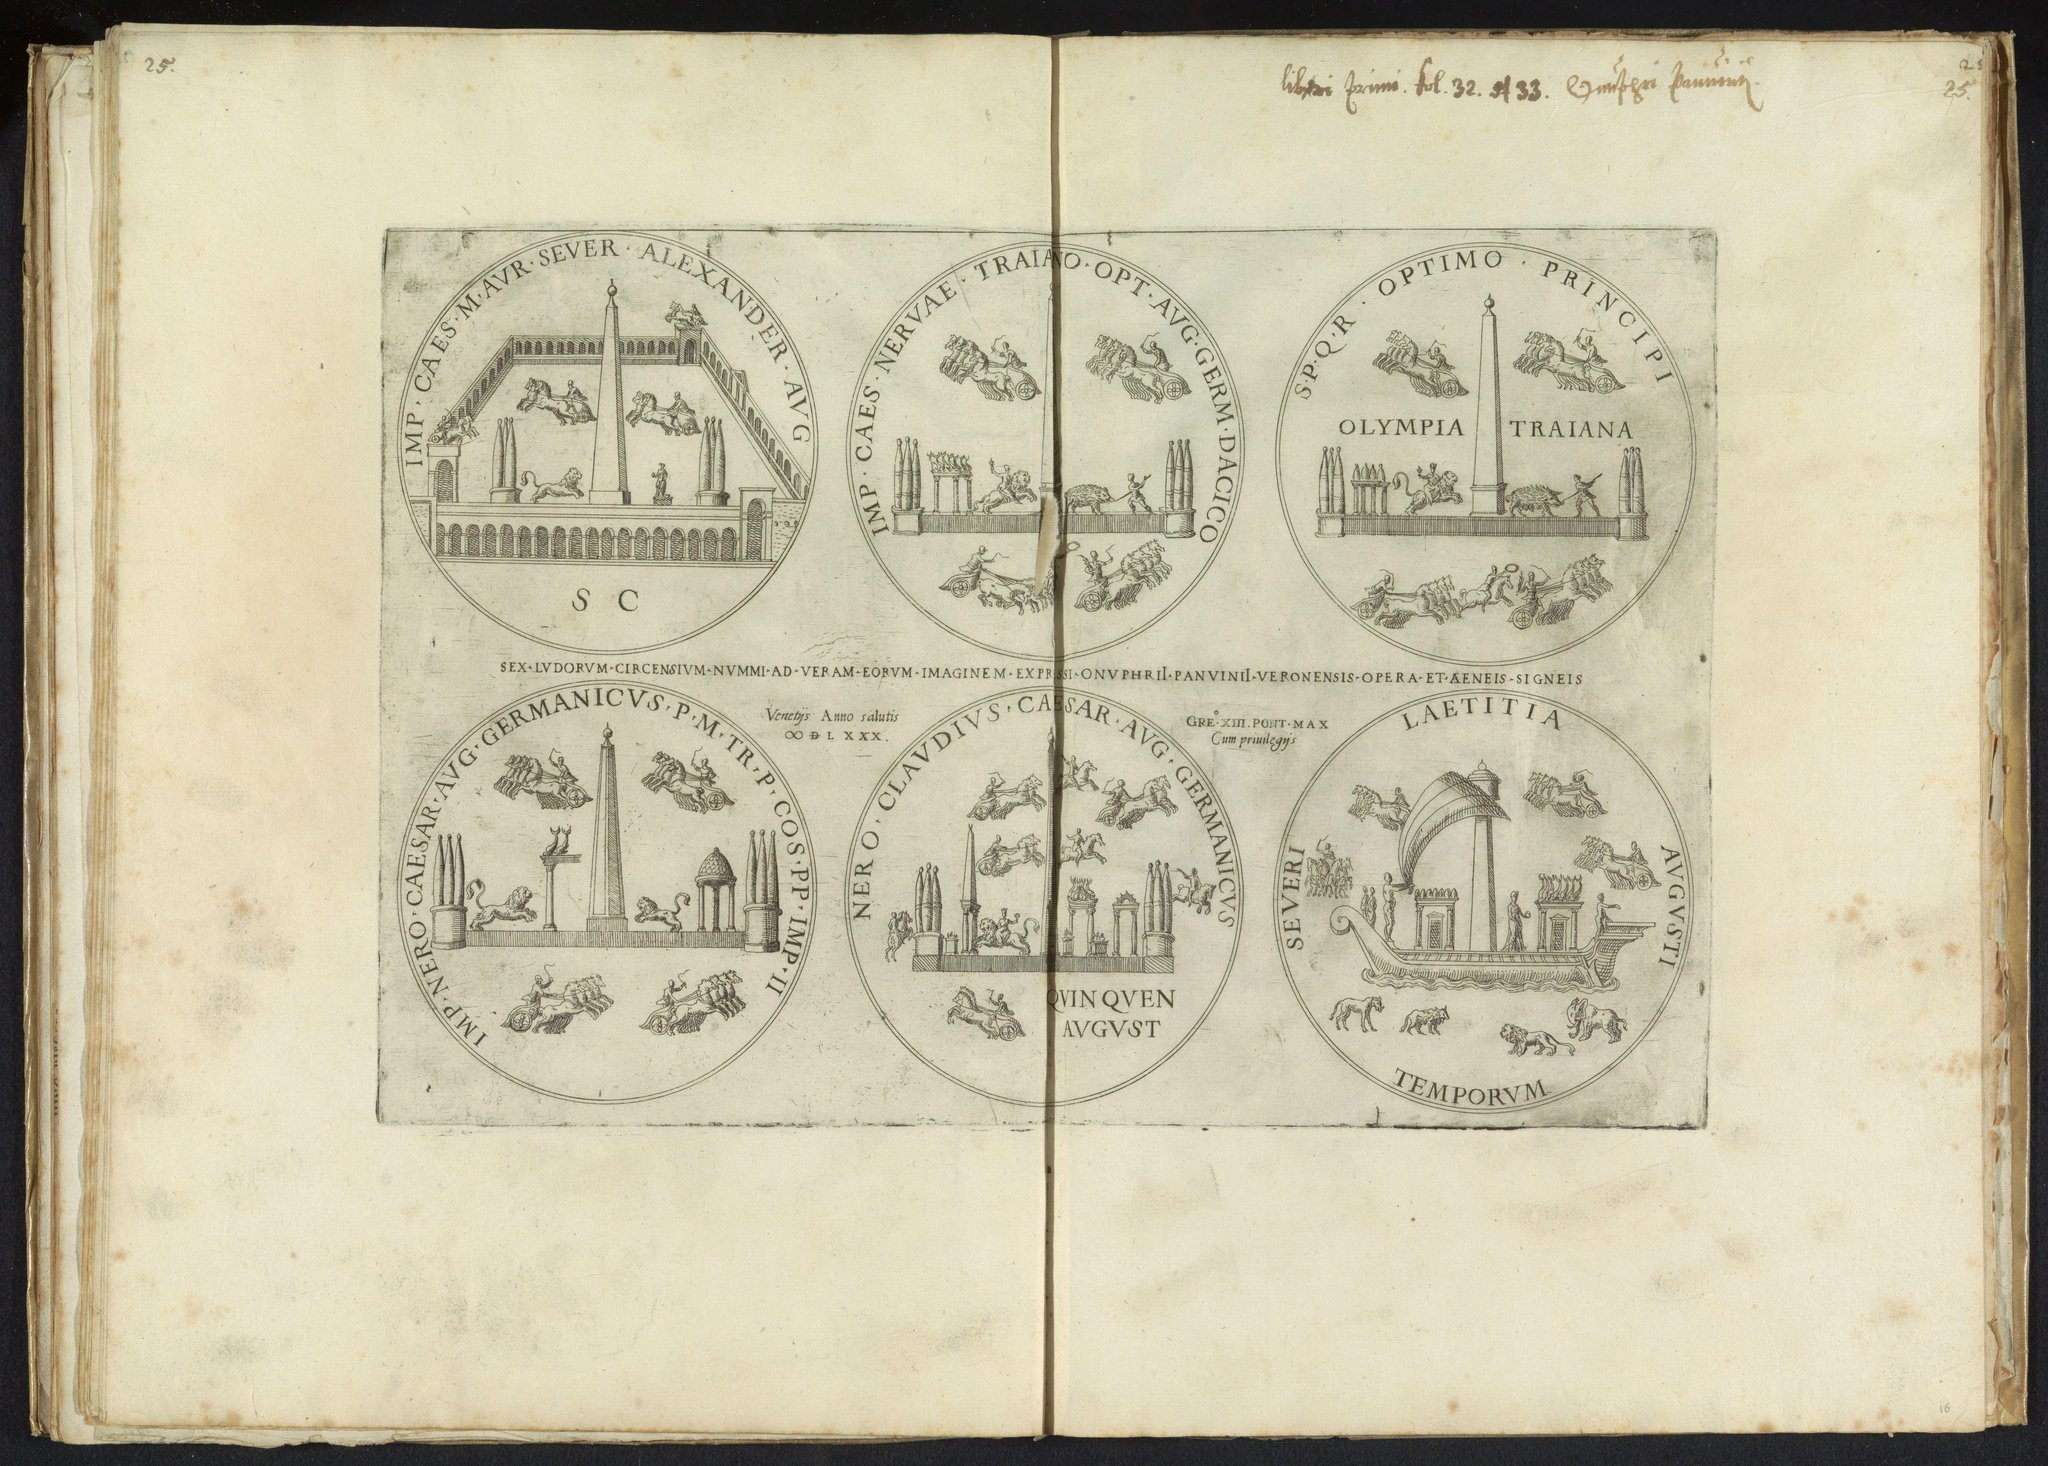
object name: album leaf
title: Zes penningen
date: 1580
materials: paper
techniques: etching, intaglio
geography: italy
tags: wagon racing with two-wheeled vehicle, e.g.: chariot, sulky, fight between man and animal, charioteer, 'auriga', coin, beasts of prey, predatory animals: lion, trunked animals: elephant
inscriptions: number: ‘25’, inscription: ‘libri [...] fol. 32 - 33 [...]’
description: Twee rijen van drie penningen ter herinnering aan historische sportwedstrijden. In het midden en op de penningen tekst in het Latijn. Prent maakt deel uit van een album.